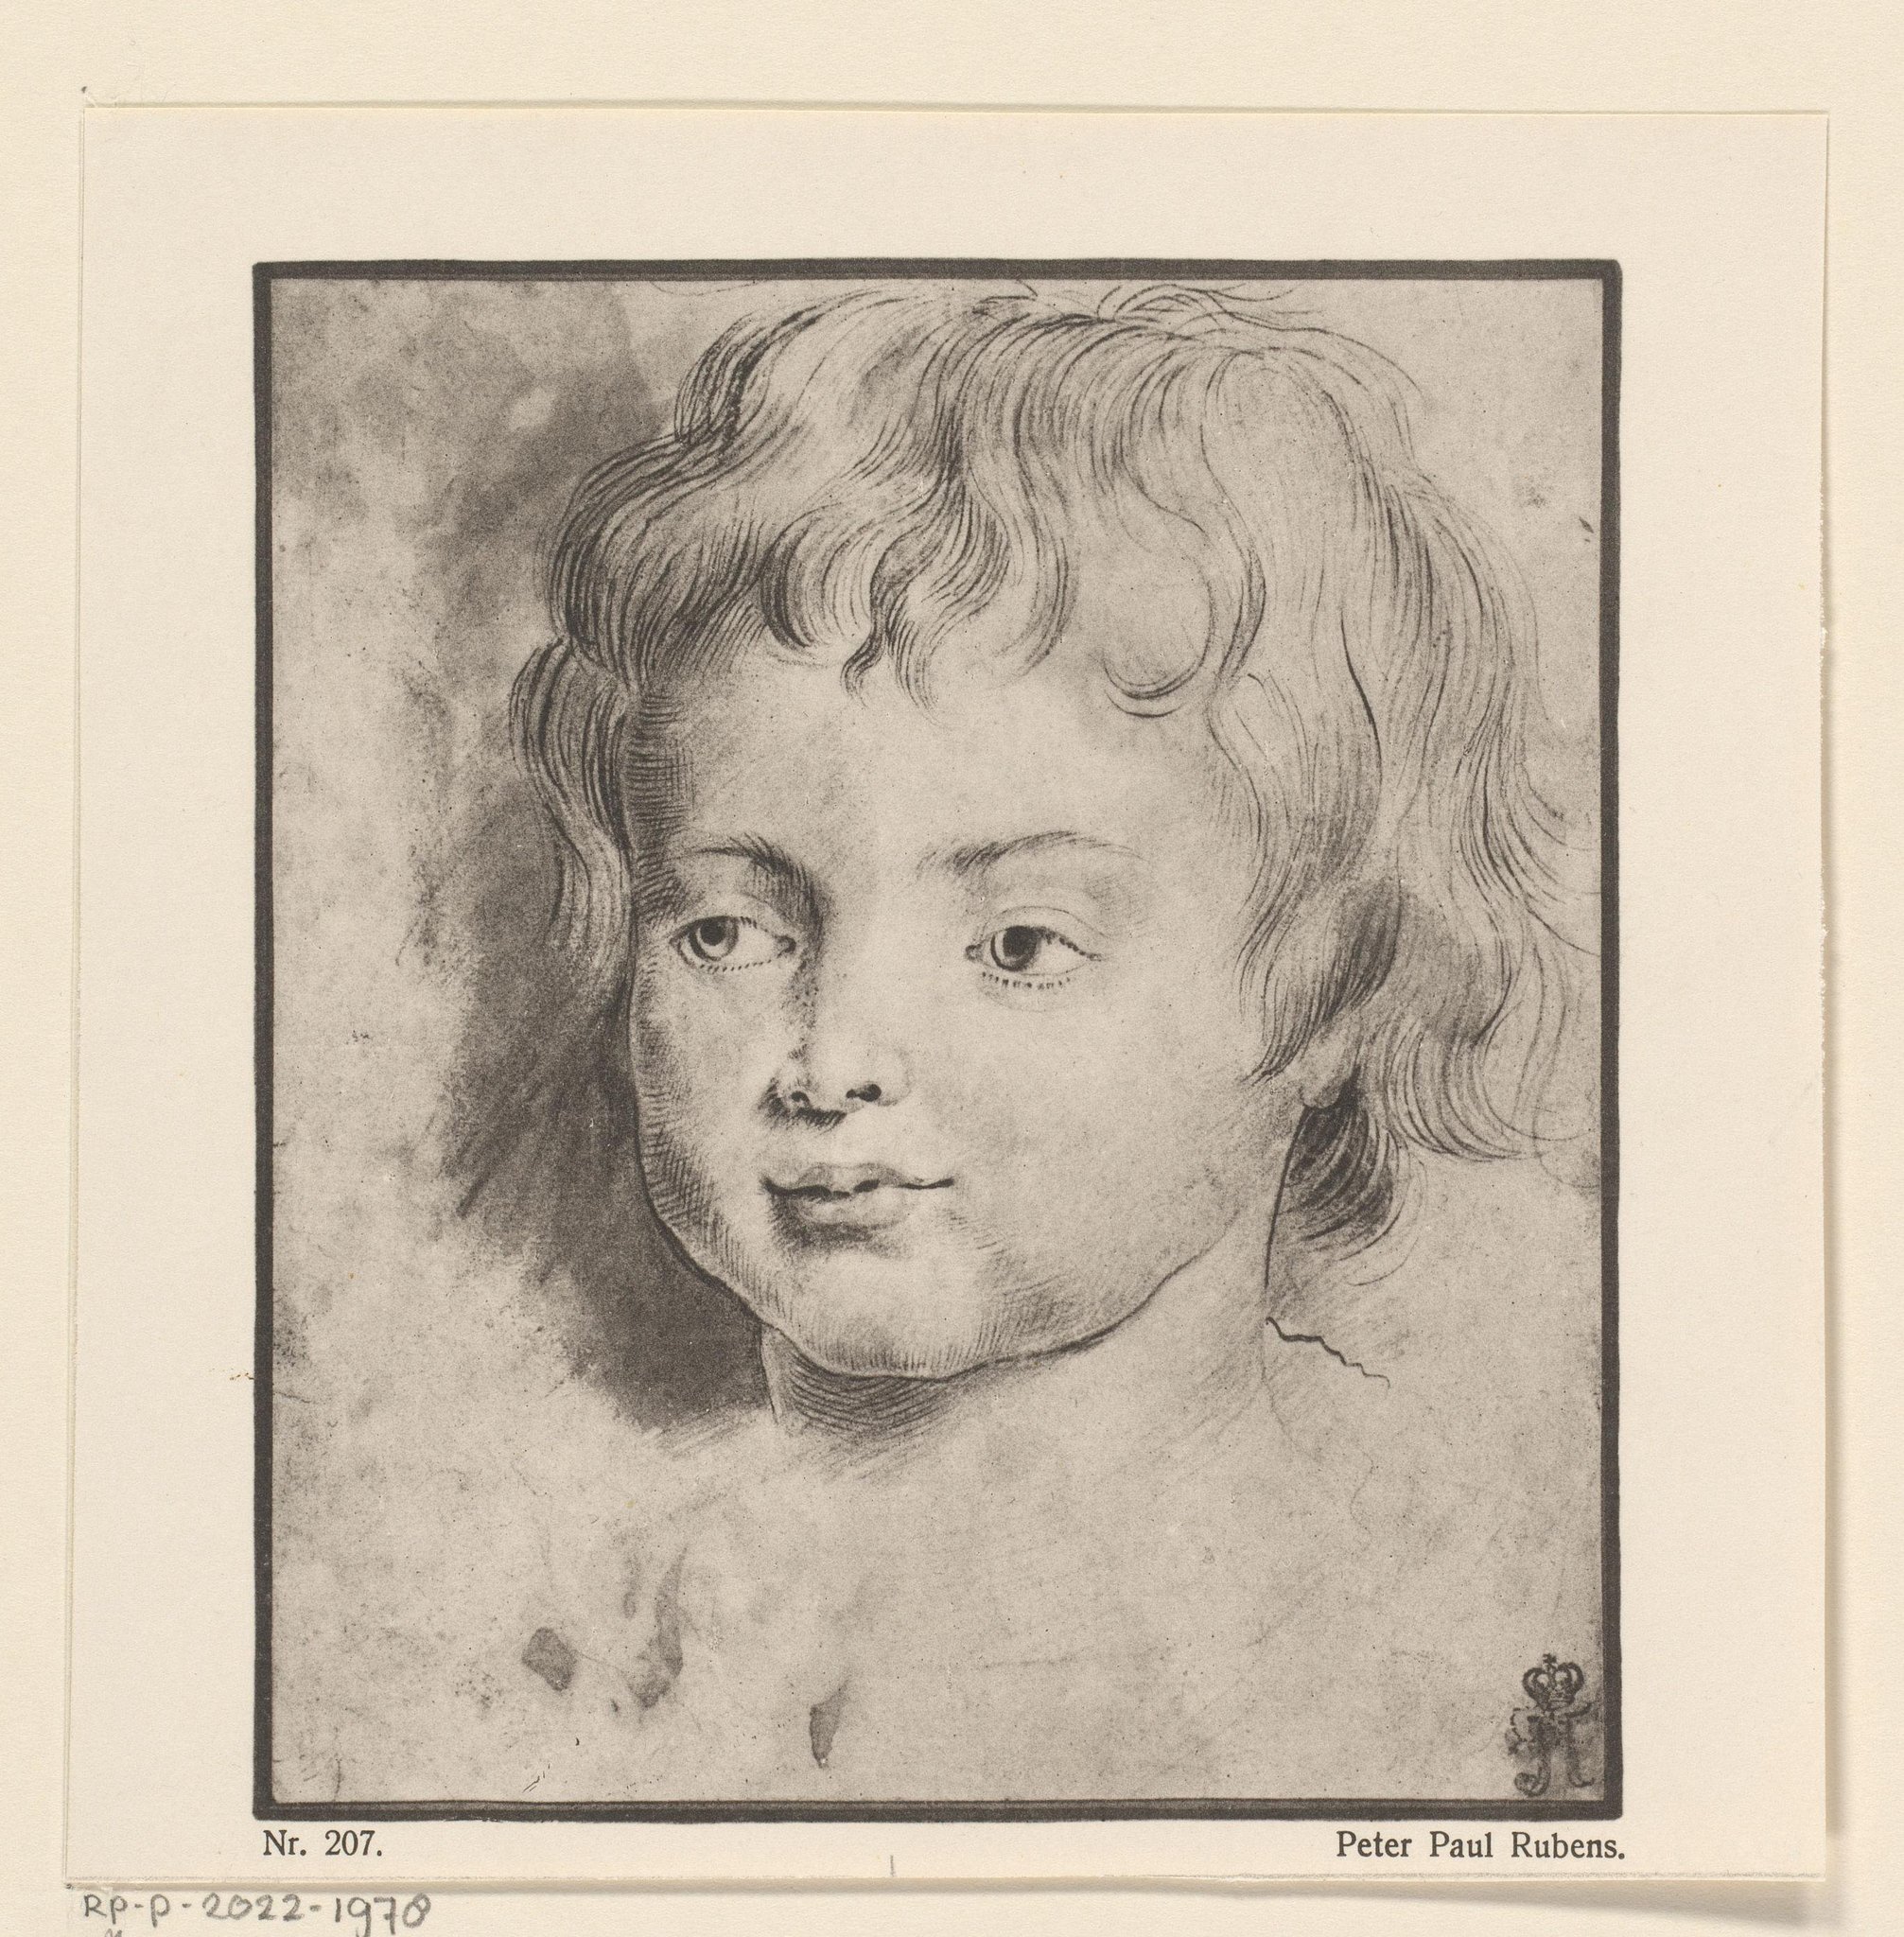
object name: photomechanical print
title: Portret van Albert Rubens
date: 1875-1930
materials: paper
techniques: photograph, letterpress printing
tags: brussels, philology (+ portrait of scholar, scientist), historical persons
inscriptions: inscription: ‘Rubens' Sohn Albert (...) Bö[...]e[...] 22 [...] 1931’